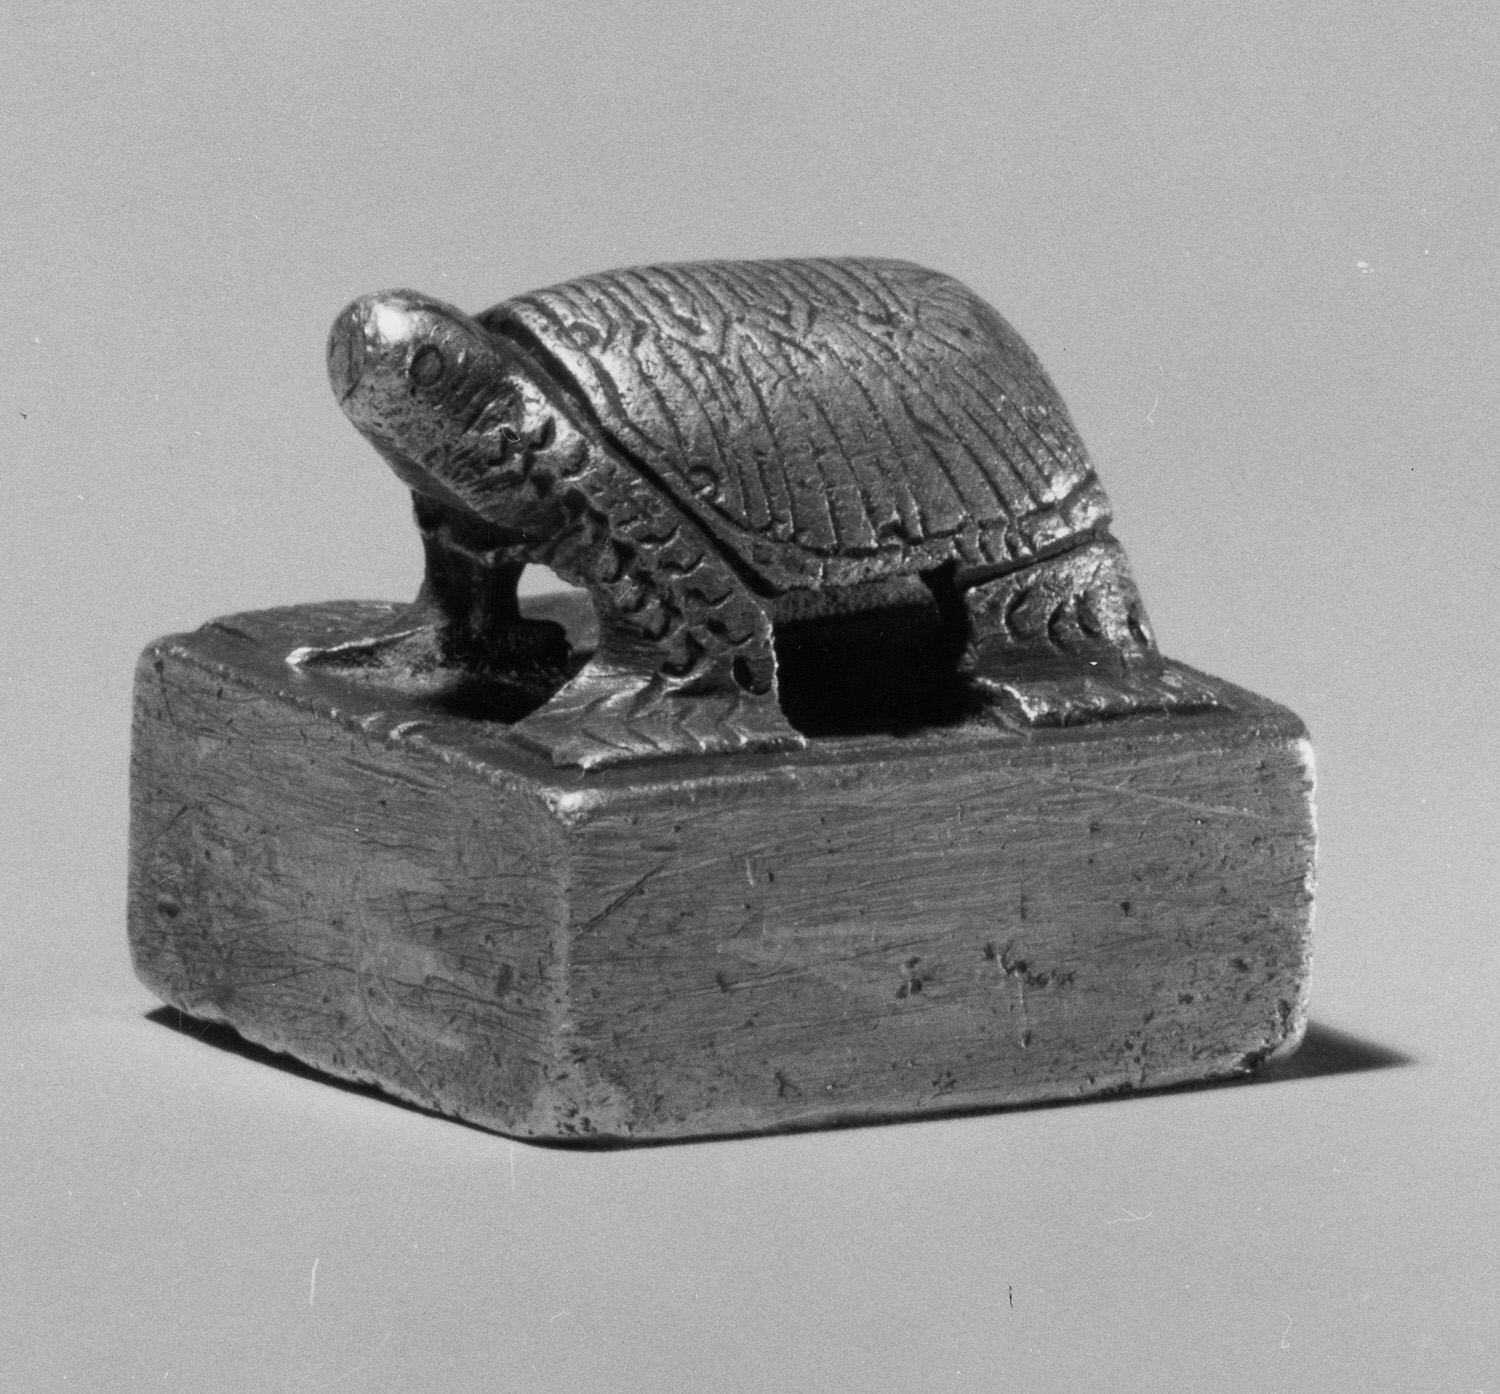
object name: seal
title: Seal with Knob in the Shape of a Turtle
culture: chinese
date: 1-200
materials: silver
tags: turtles